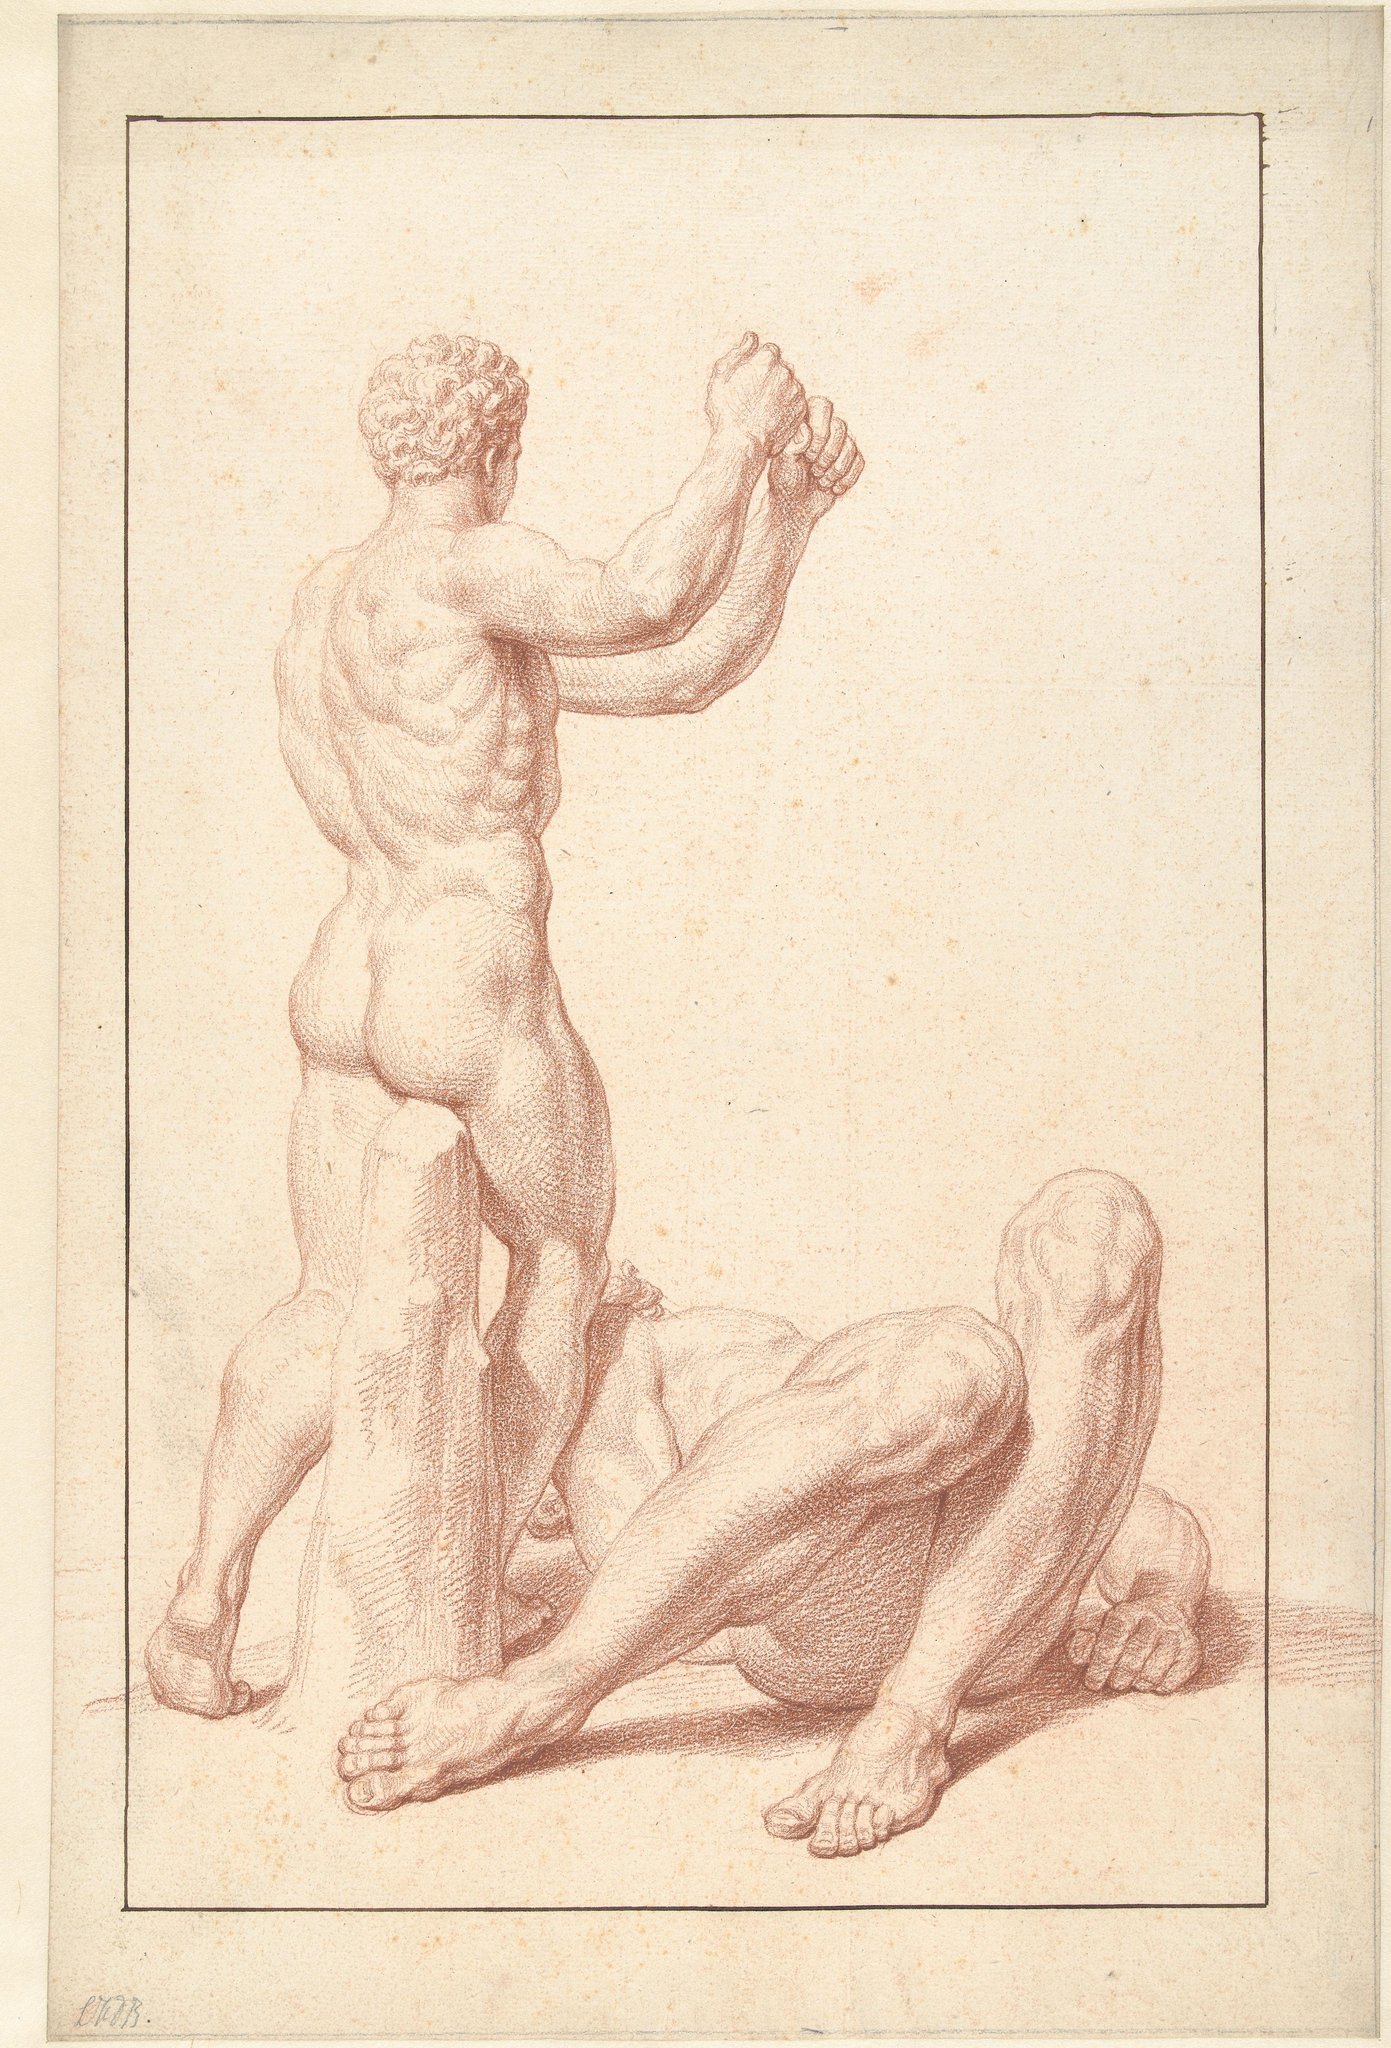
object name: drawing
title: Beeld van een jongen met opgeheven armen, op de rug gezien, bij een liggende man met baard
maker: louis fabritius dubourg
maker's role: draughtsman, print maker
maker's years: 1693-1775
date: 1703-1775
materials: chalk, paper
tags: the (nude) human figure; 'corpo humano' (ripa) (+ two persons)